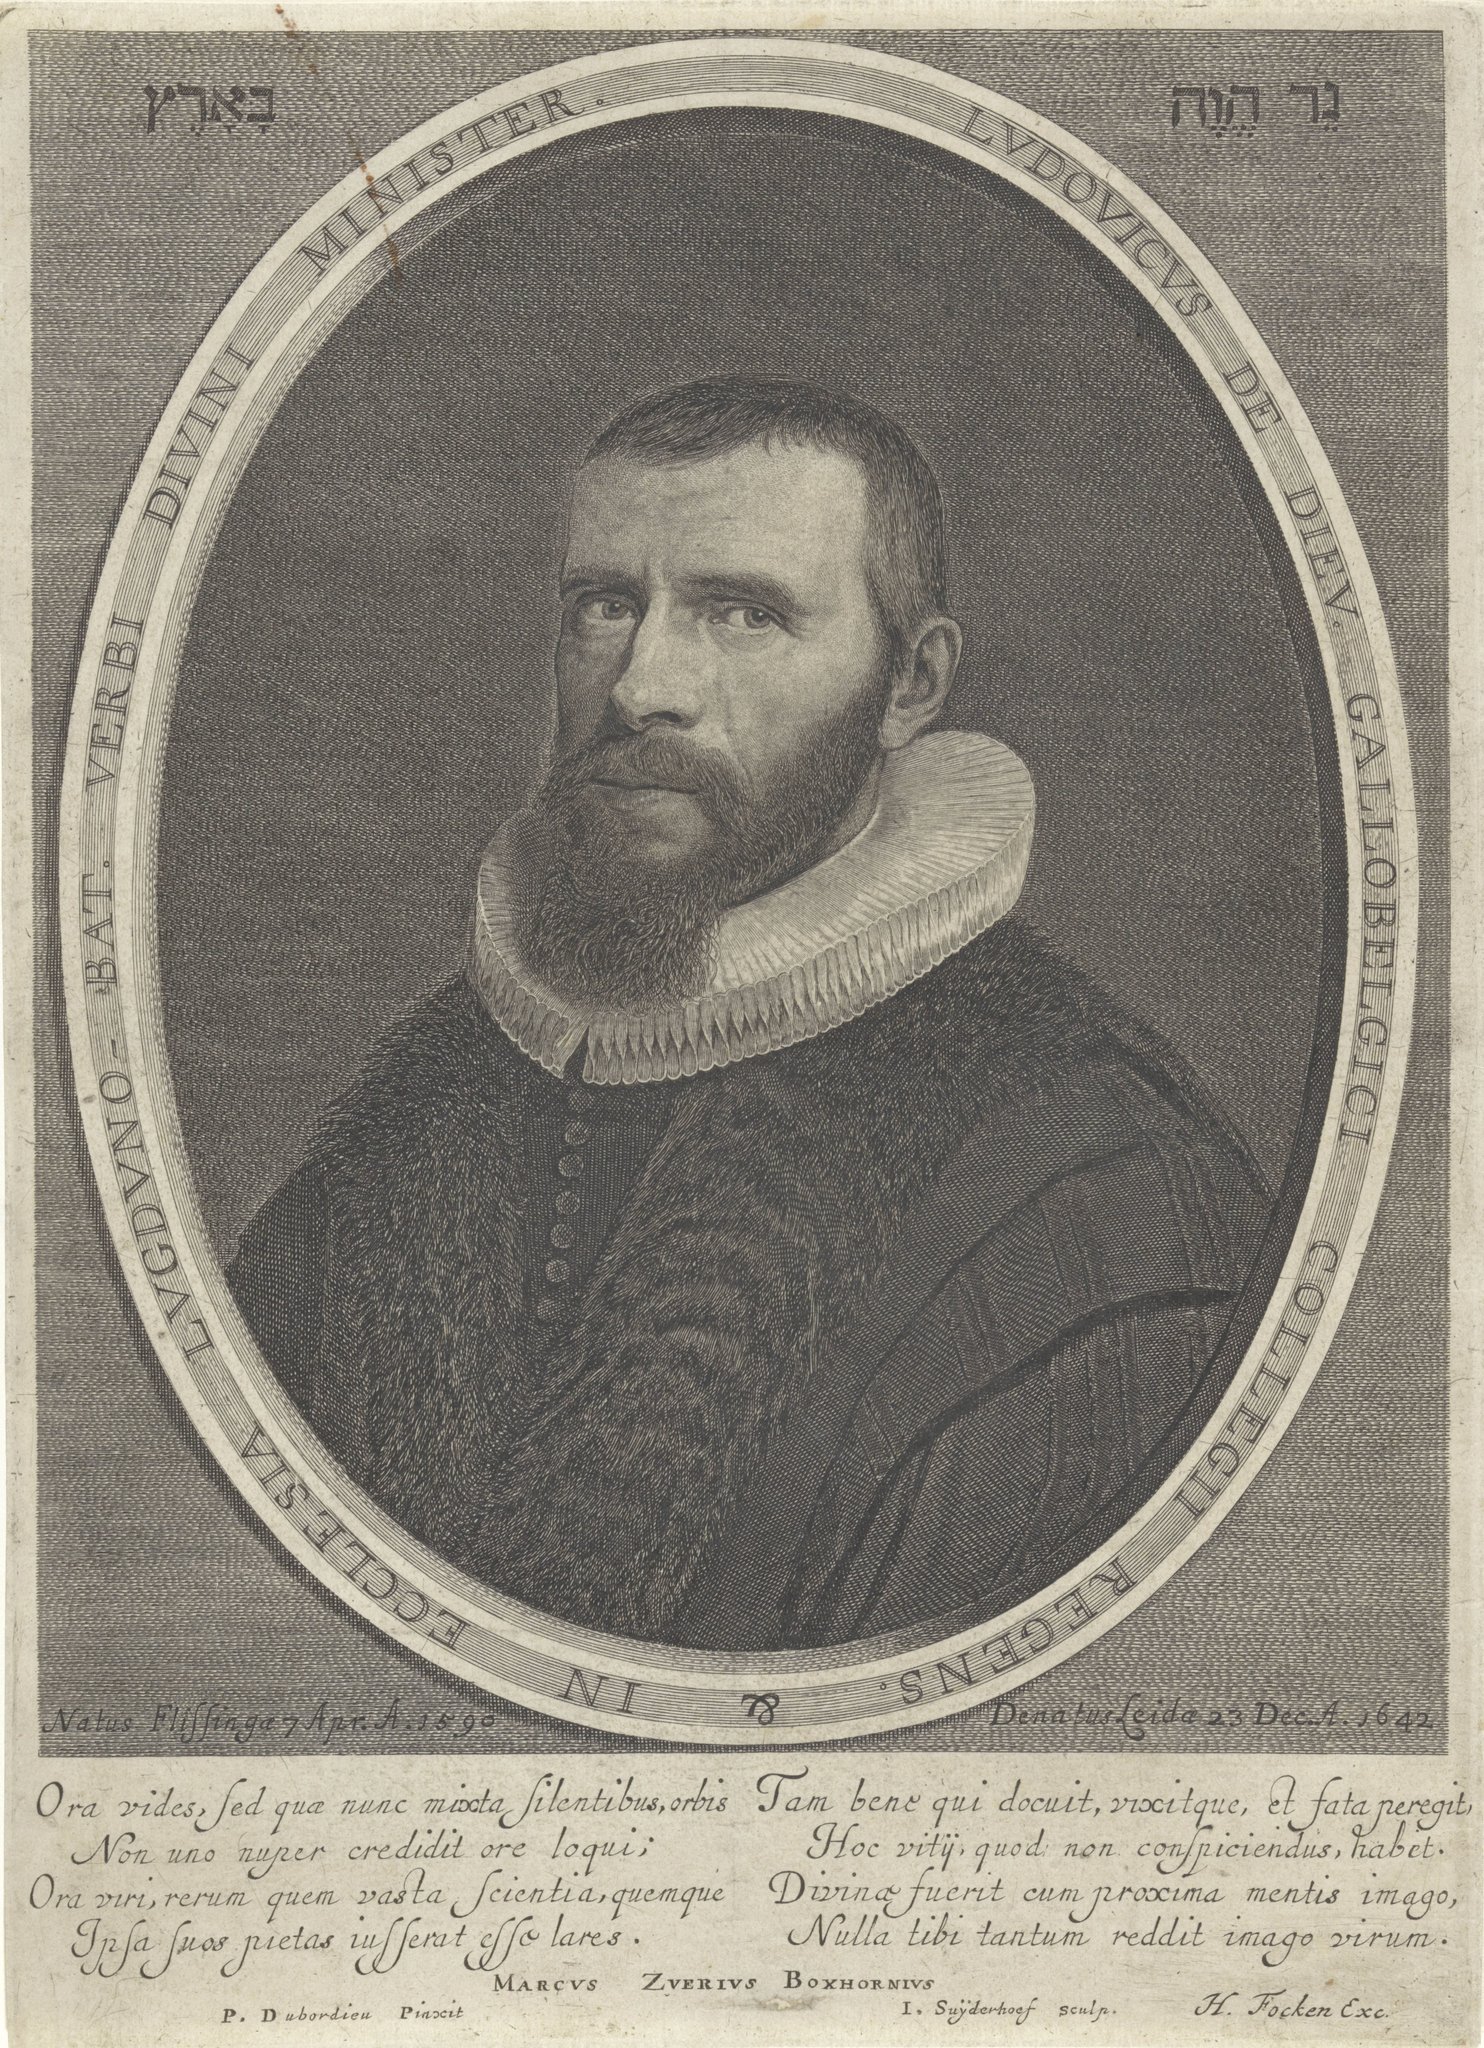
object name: print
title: Portret van Lodewijk de Dieu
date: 1647-1700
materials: paper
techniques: engraving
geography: amsterdam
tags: leiden, functionaries and dignitaries ~ protestant churches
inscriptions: collector's mark: Lugt 2228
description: Portret van Lodewijk de Dieu, Waals predikant te Leiden. Onderaan in de marge twee vierregelige verzen in het Latijn.